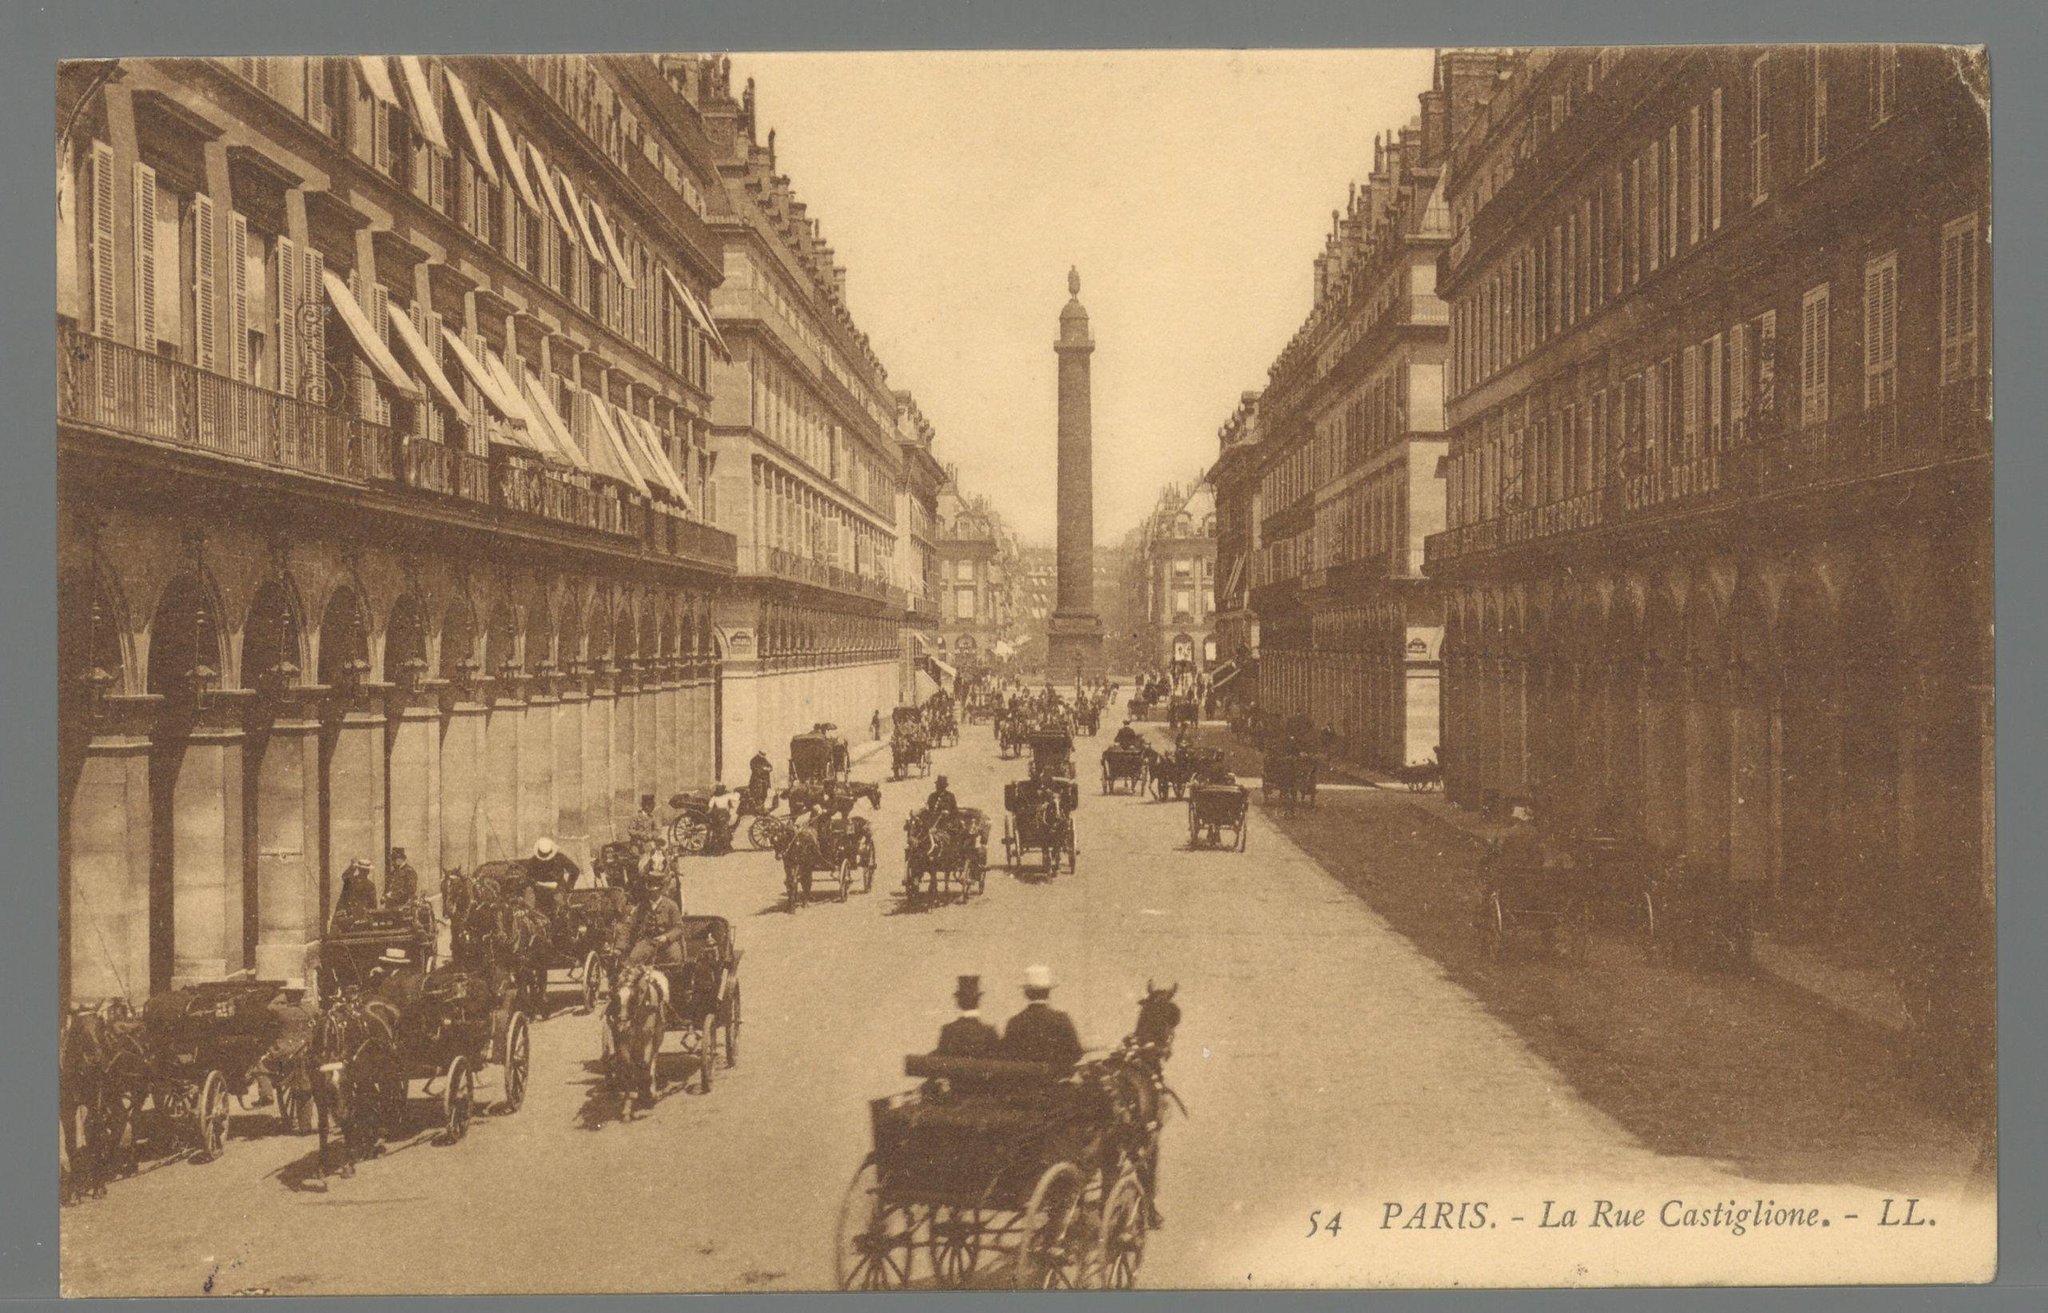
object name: ansichtkaart, prentbriefkaart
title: Paris. La Rue Castiglione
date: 1904-1906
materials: cardboard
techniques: photograph, writing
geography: paris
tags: four-wheeled, animal-drawn vehicle, e.g.: cab, carriage, coach, monument, statue, street (+ city(-scape) with figures, staffage)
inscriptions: postage stamp